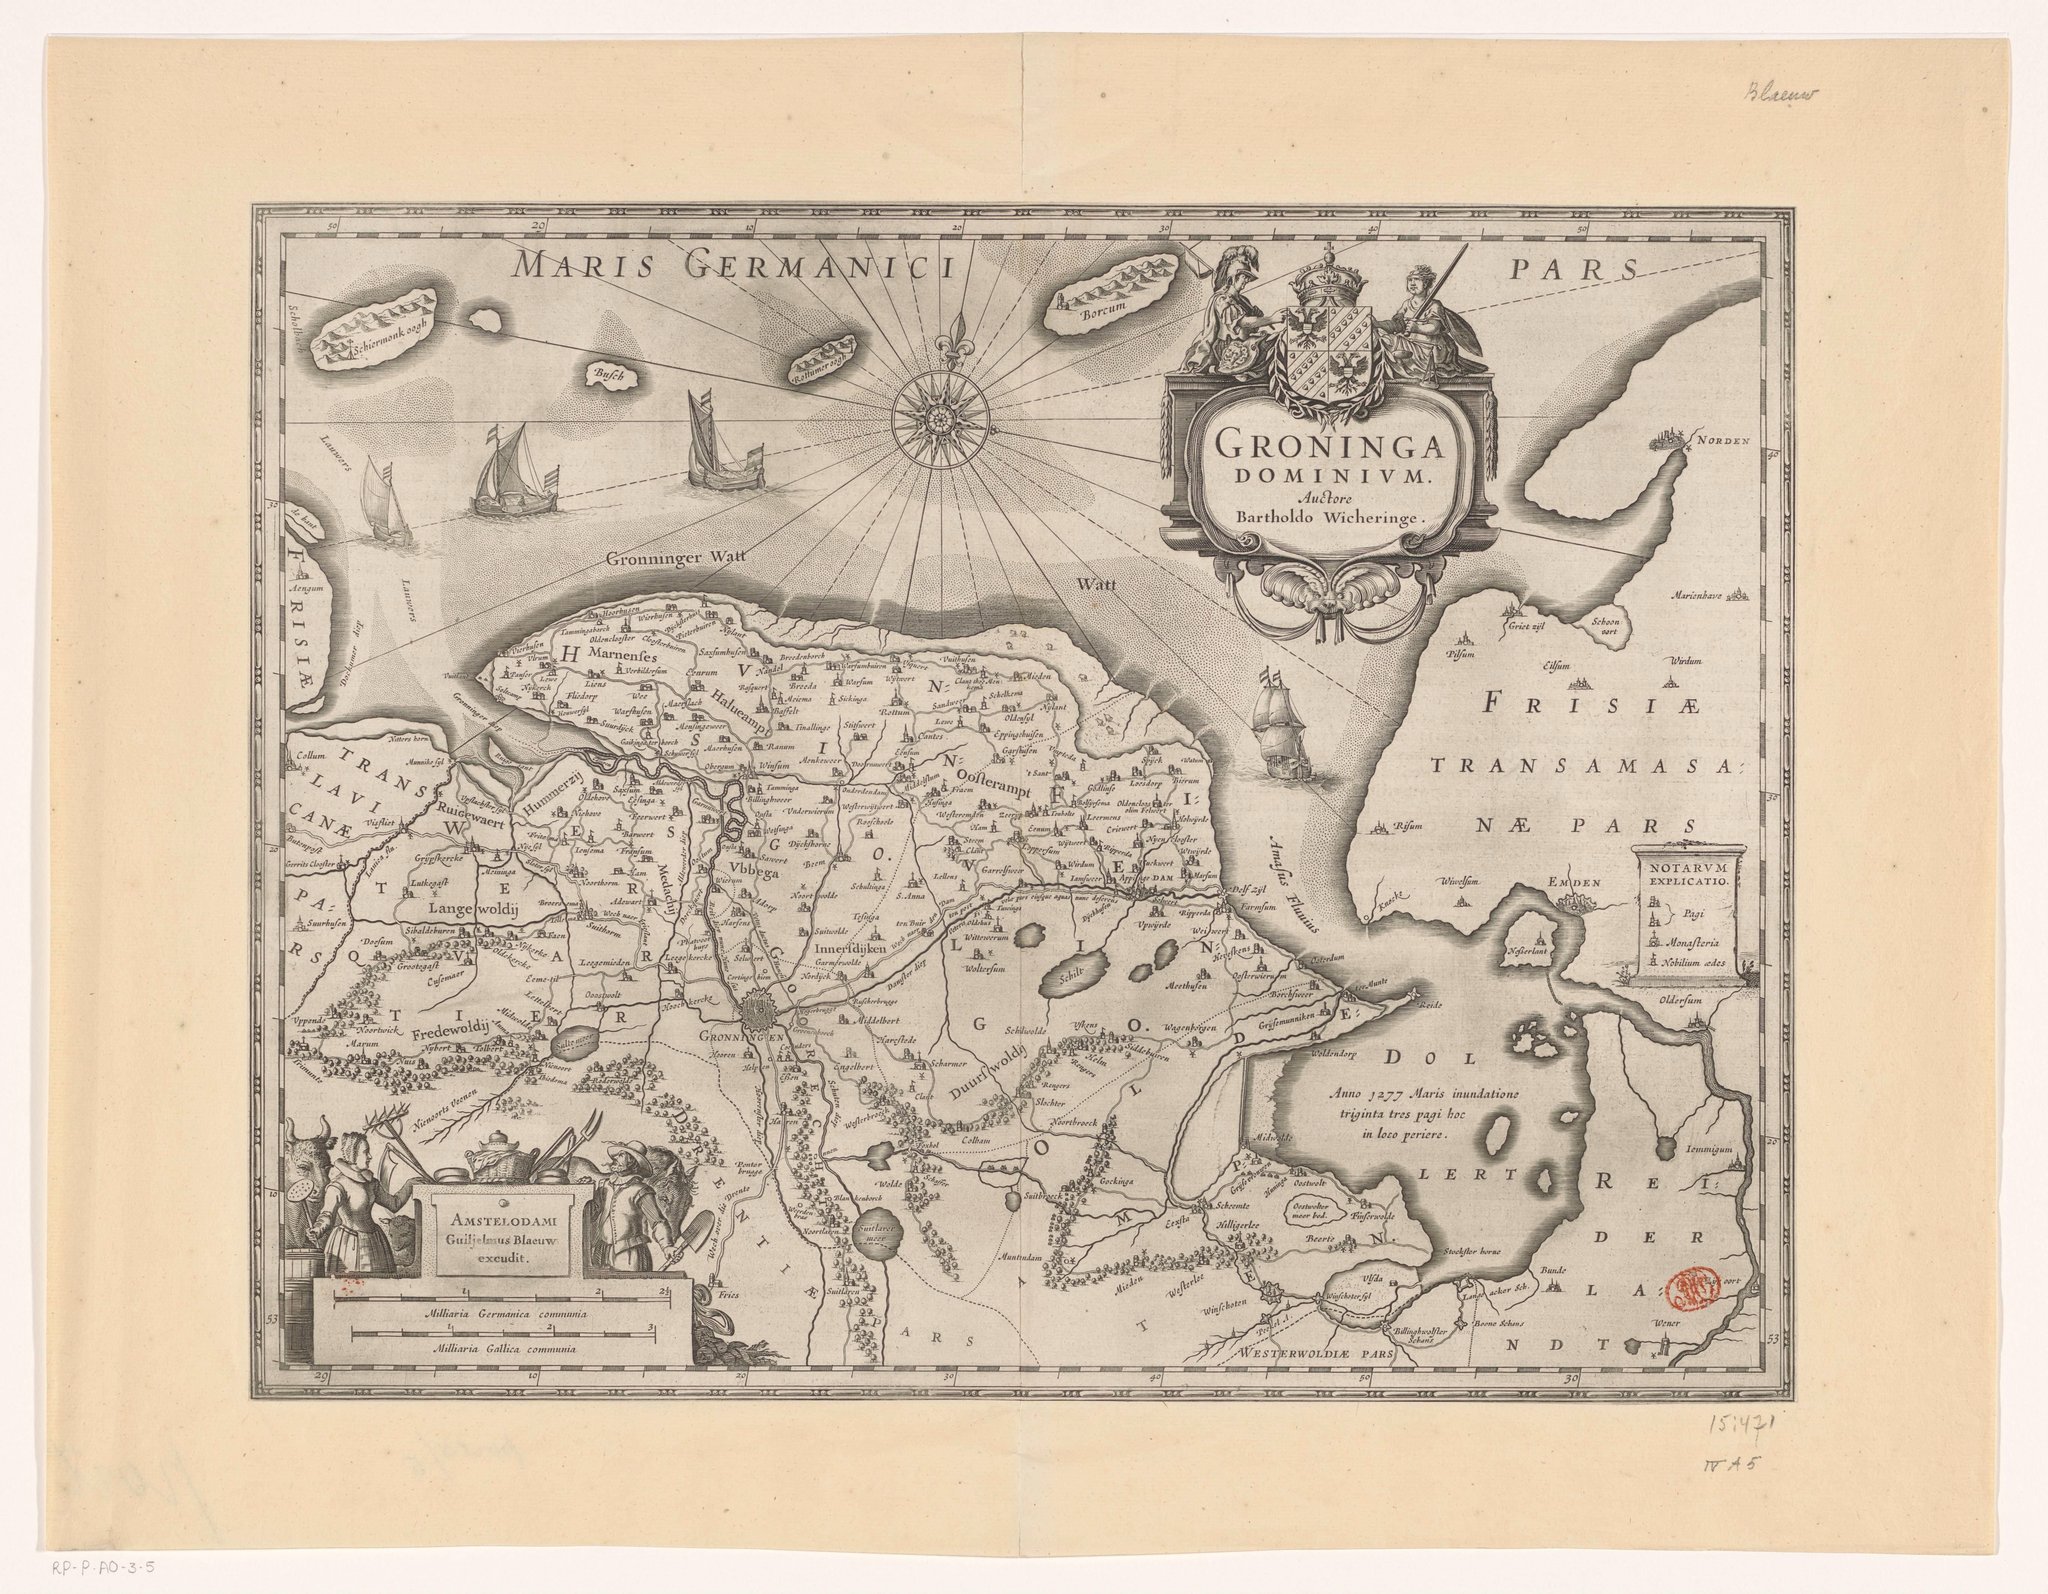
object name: map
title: Groninga dominium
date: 1640-1662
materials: paper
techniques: engraving, etching, letterpress printing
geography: amsterdam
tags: coat of arms (as symbol of the state, etc.), maps of separate countries or regions, (story of) minerva (pallas, athena), farmers, justitia (justice) as roman personification, groningen (province)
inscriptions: collector's mark: Lugt 2228, collector's mark: Lugt 195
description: Prent of gebruikt in: Blaeu, Willem Janszoon en Johannes Willemszoon. Theatrum Orbis Terrarum, sive Atlas Novus, in quo tabulae et descriptiones omnium regionum. 3 delen. Amsterdam: Johannes Willemszoon en Cornelis Blaeu, 1640-1643, dl. 1 (1640). Of in: Blaeu, Willem Janszoon en Johannes Willemszoon. Theatrum Orbis Terrarum, sive Atlas Novus, in quo tabulae et descriptiones omnium regionum. 4 delen. Amsterdam: Johannes Willemszoon en Cornelis Blaeu, 1644-1645, dl. 1 (1644). Of in: Prent gebruikt in: Blaeu, Johannes Willemszoon. Atlas Maior, sive Cosmographia Blaviana, qua solum, salum, coelum, accuratissime describuntur. Amsterdam: Johannes Willemszoon Blaeu, 1662, dl. 4.